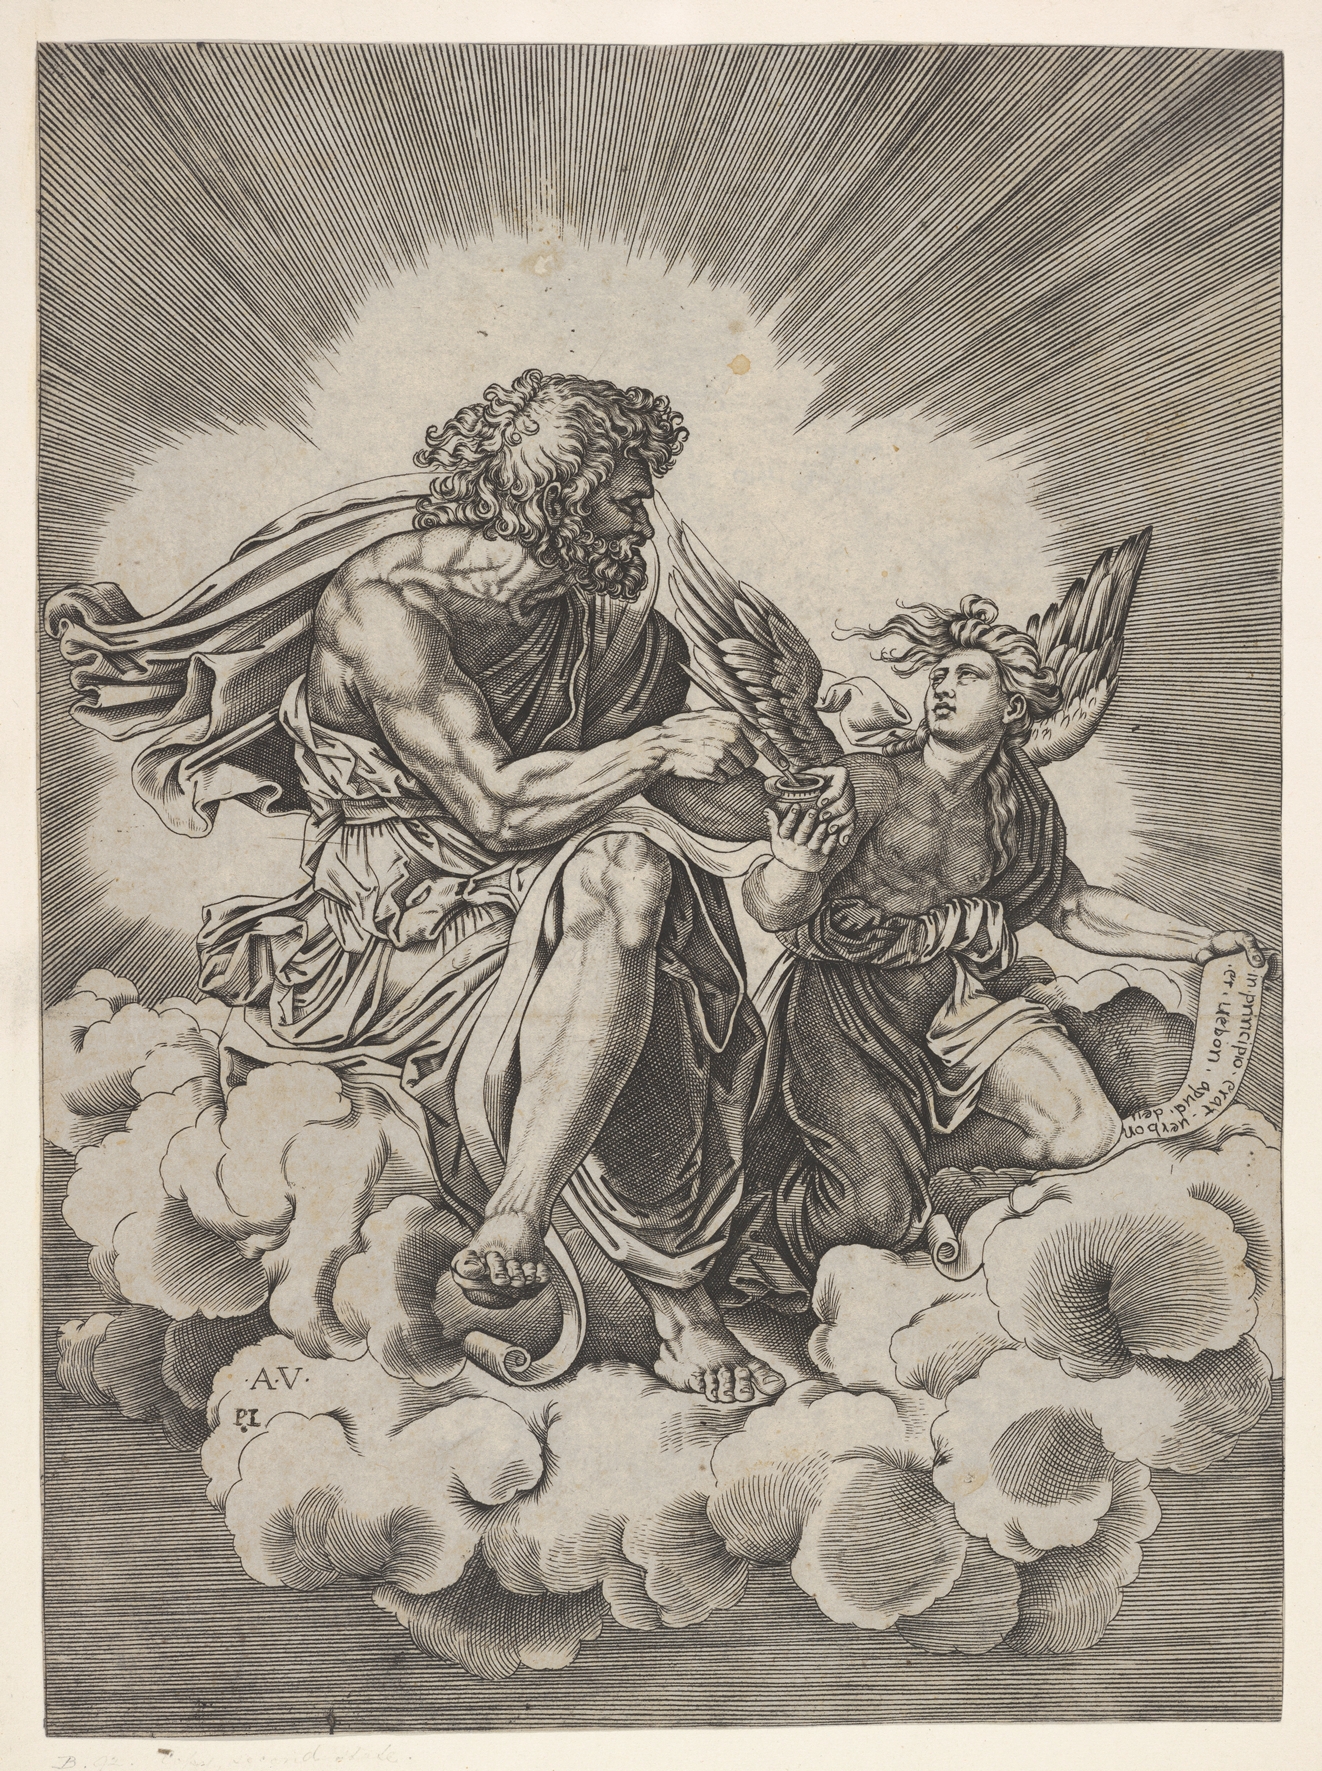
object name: print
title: St. Matthew, seated on a cloud with legs crossed and dipping a quill into an inkwell held by an angel, who also holds an inscribed scroll, from a series of the four evangelists after Agostino Veneziano, which are in turn after Giulio Romano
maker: anonymous, italian, 16th century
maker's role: artist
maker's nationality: italian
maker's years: 1500-1600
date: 1518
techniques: engraving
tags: clouds,angels,saint matthew